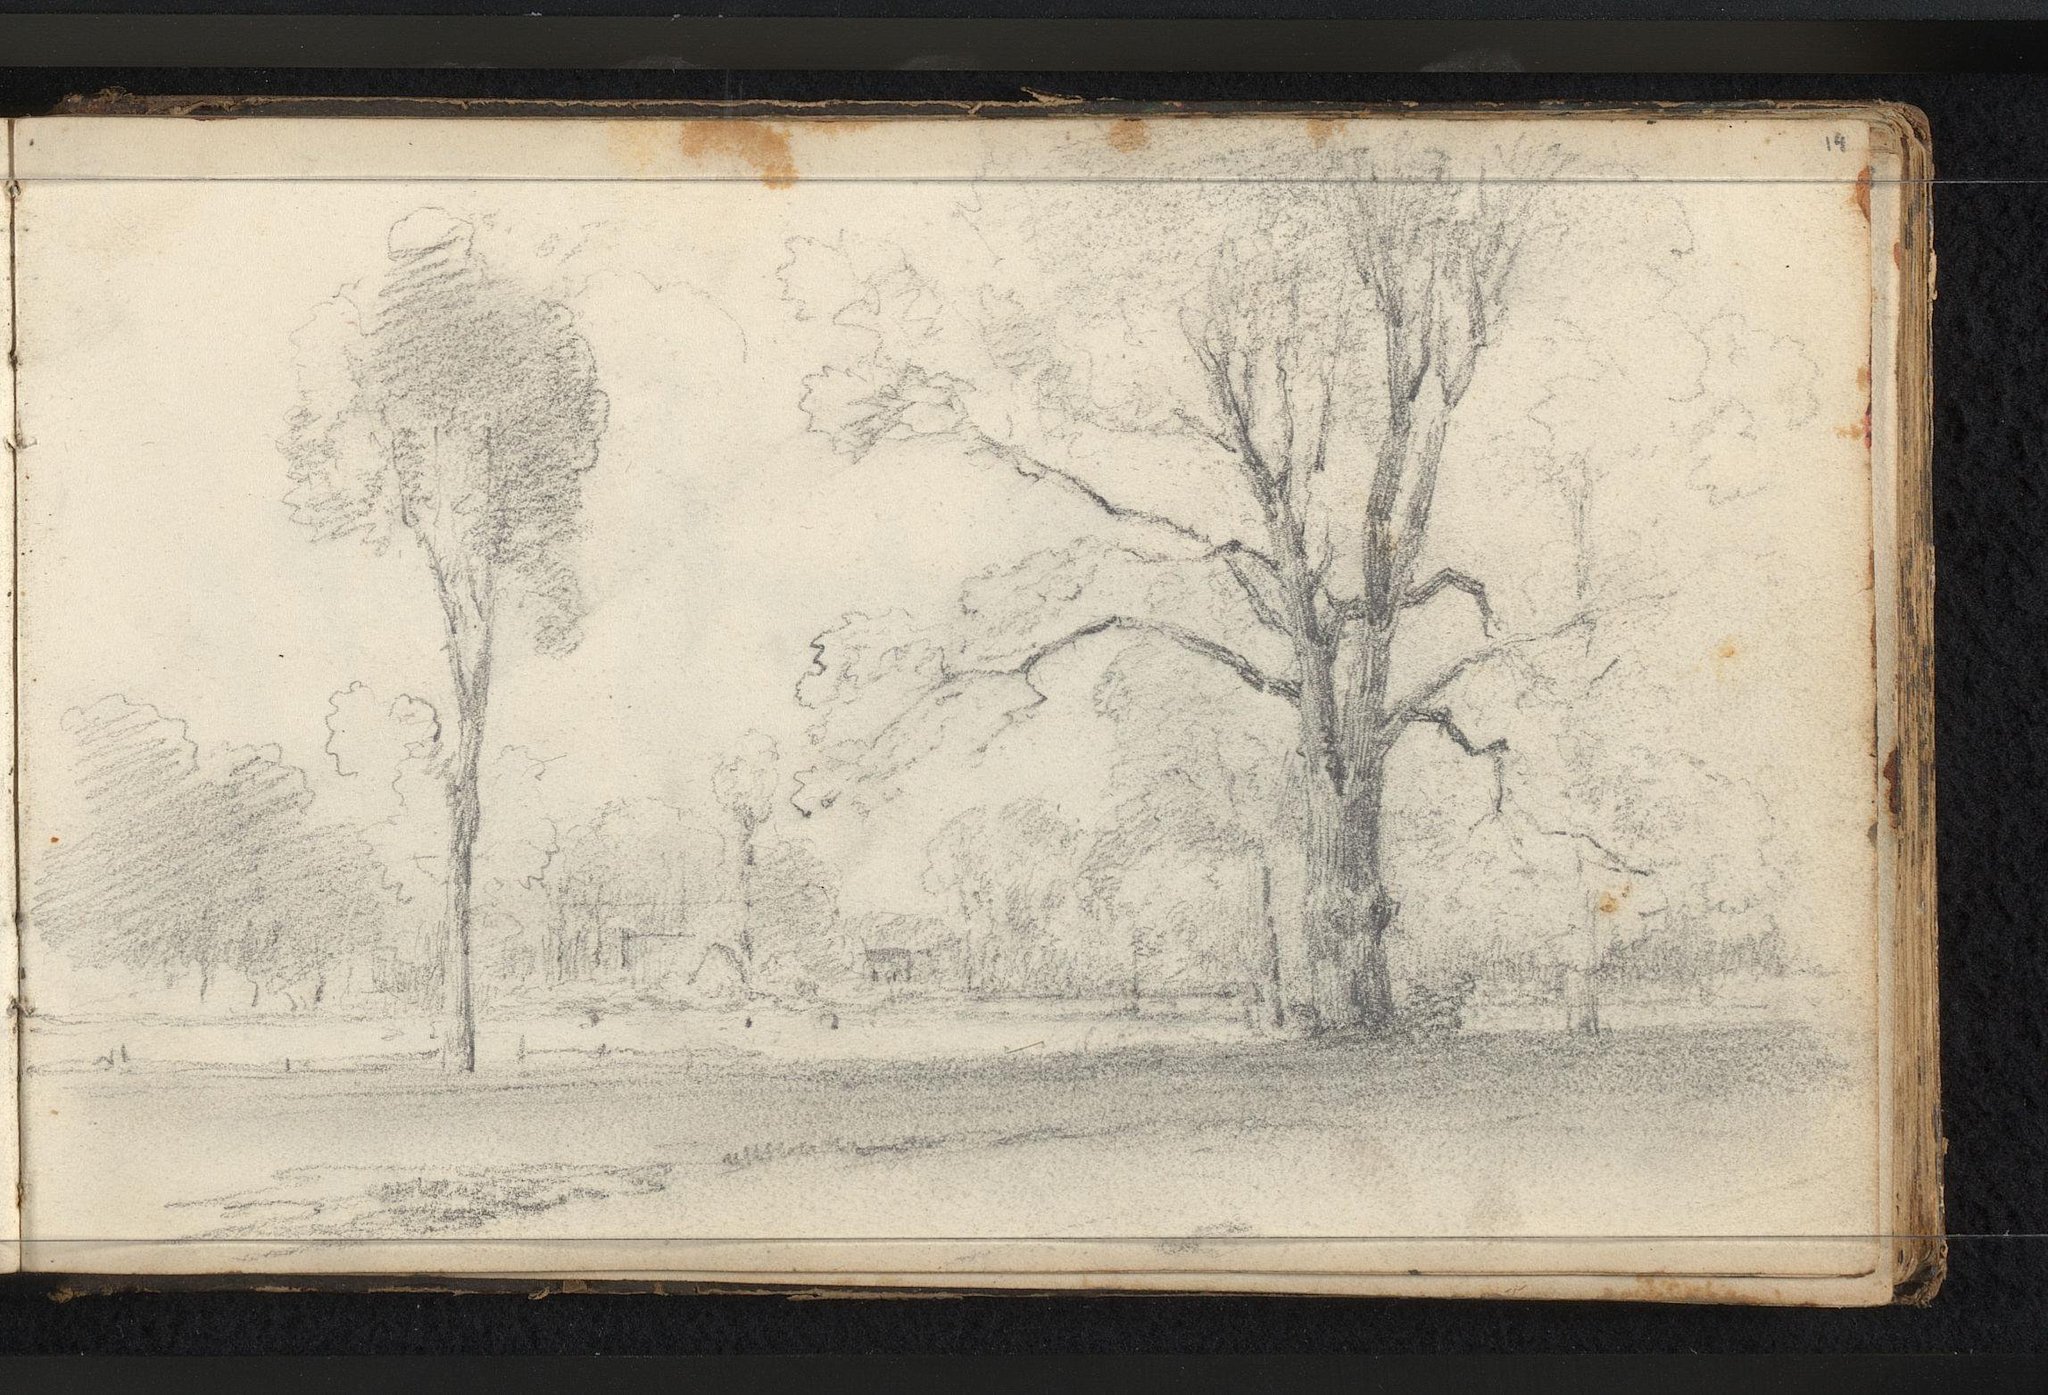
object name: sketchbook leaf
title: Landschap met bomen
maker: jan bedijs tom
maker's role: draughtsman, painter, print maker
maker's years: 1813-1894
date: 1828-1894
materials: paper, pencil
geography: the hague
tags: trees, landscapes, artist (in general) making preliminary designs, sketching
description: Pagina 14 recto uit een schetsboek met 54 bladen.